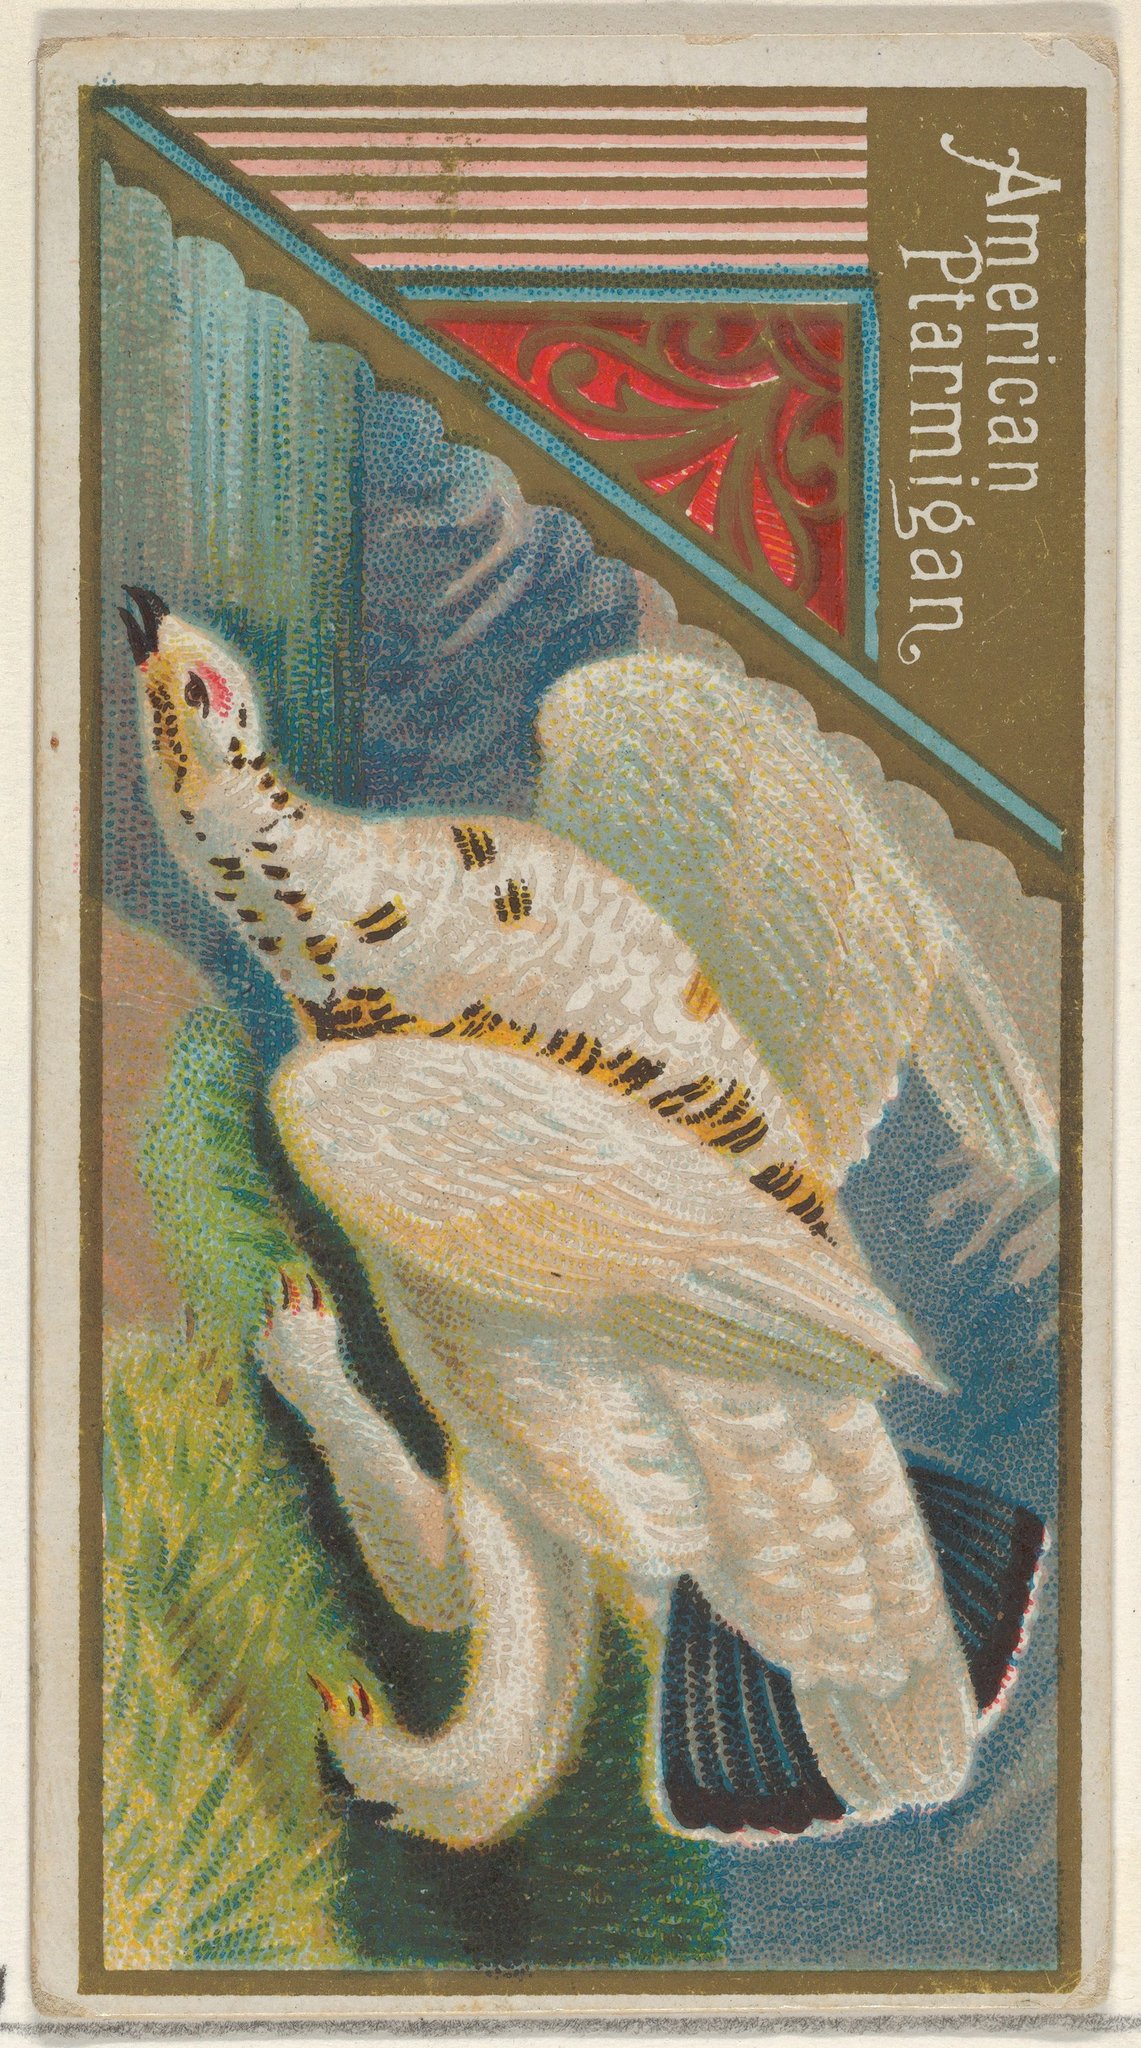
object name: print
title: American Ptarmigan, from the Game Birds series (N13) for Allen & Ginter Cigarettes Brands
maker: allen & ginter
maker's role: publisher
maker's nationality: american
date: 1889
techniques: color lithograph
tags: birds